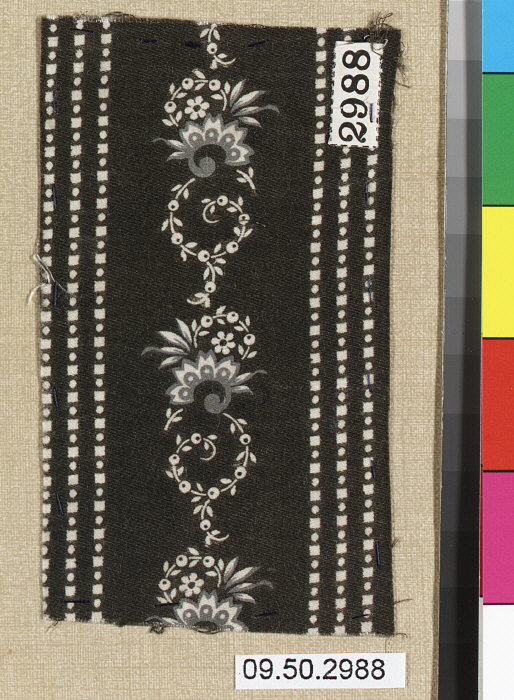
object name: piece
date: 1801-1900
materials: cotton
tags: flowers,leaves